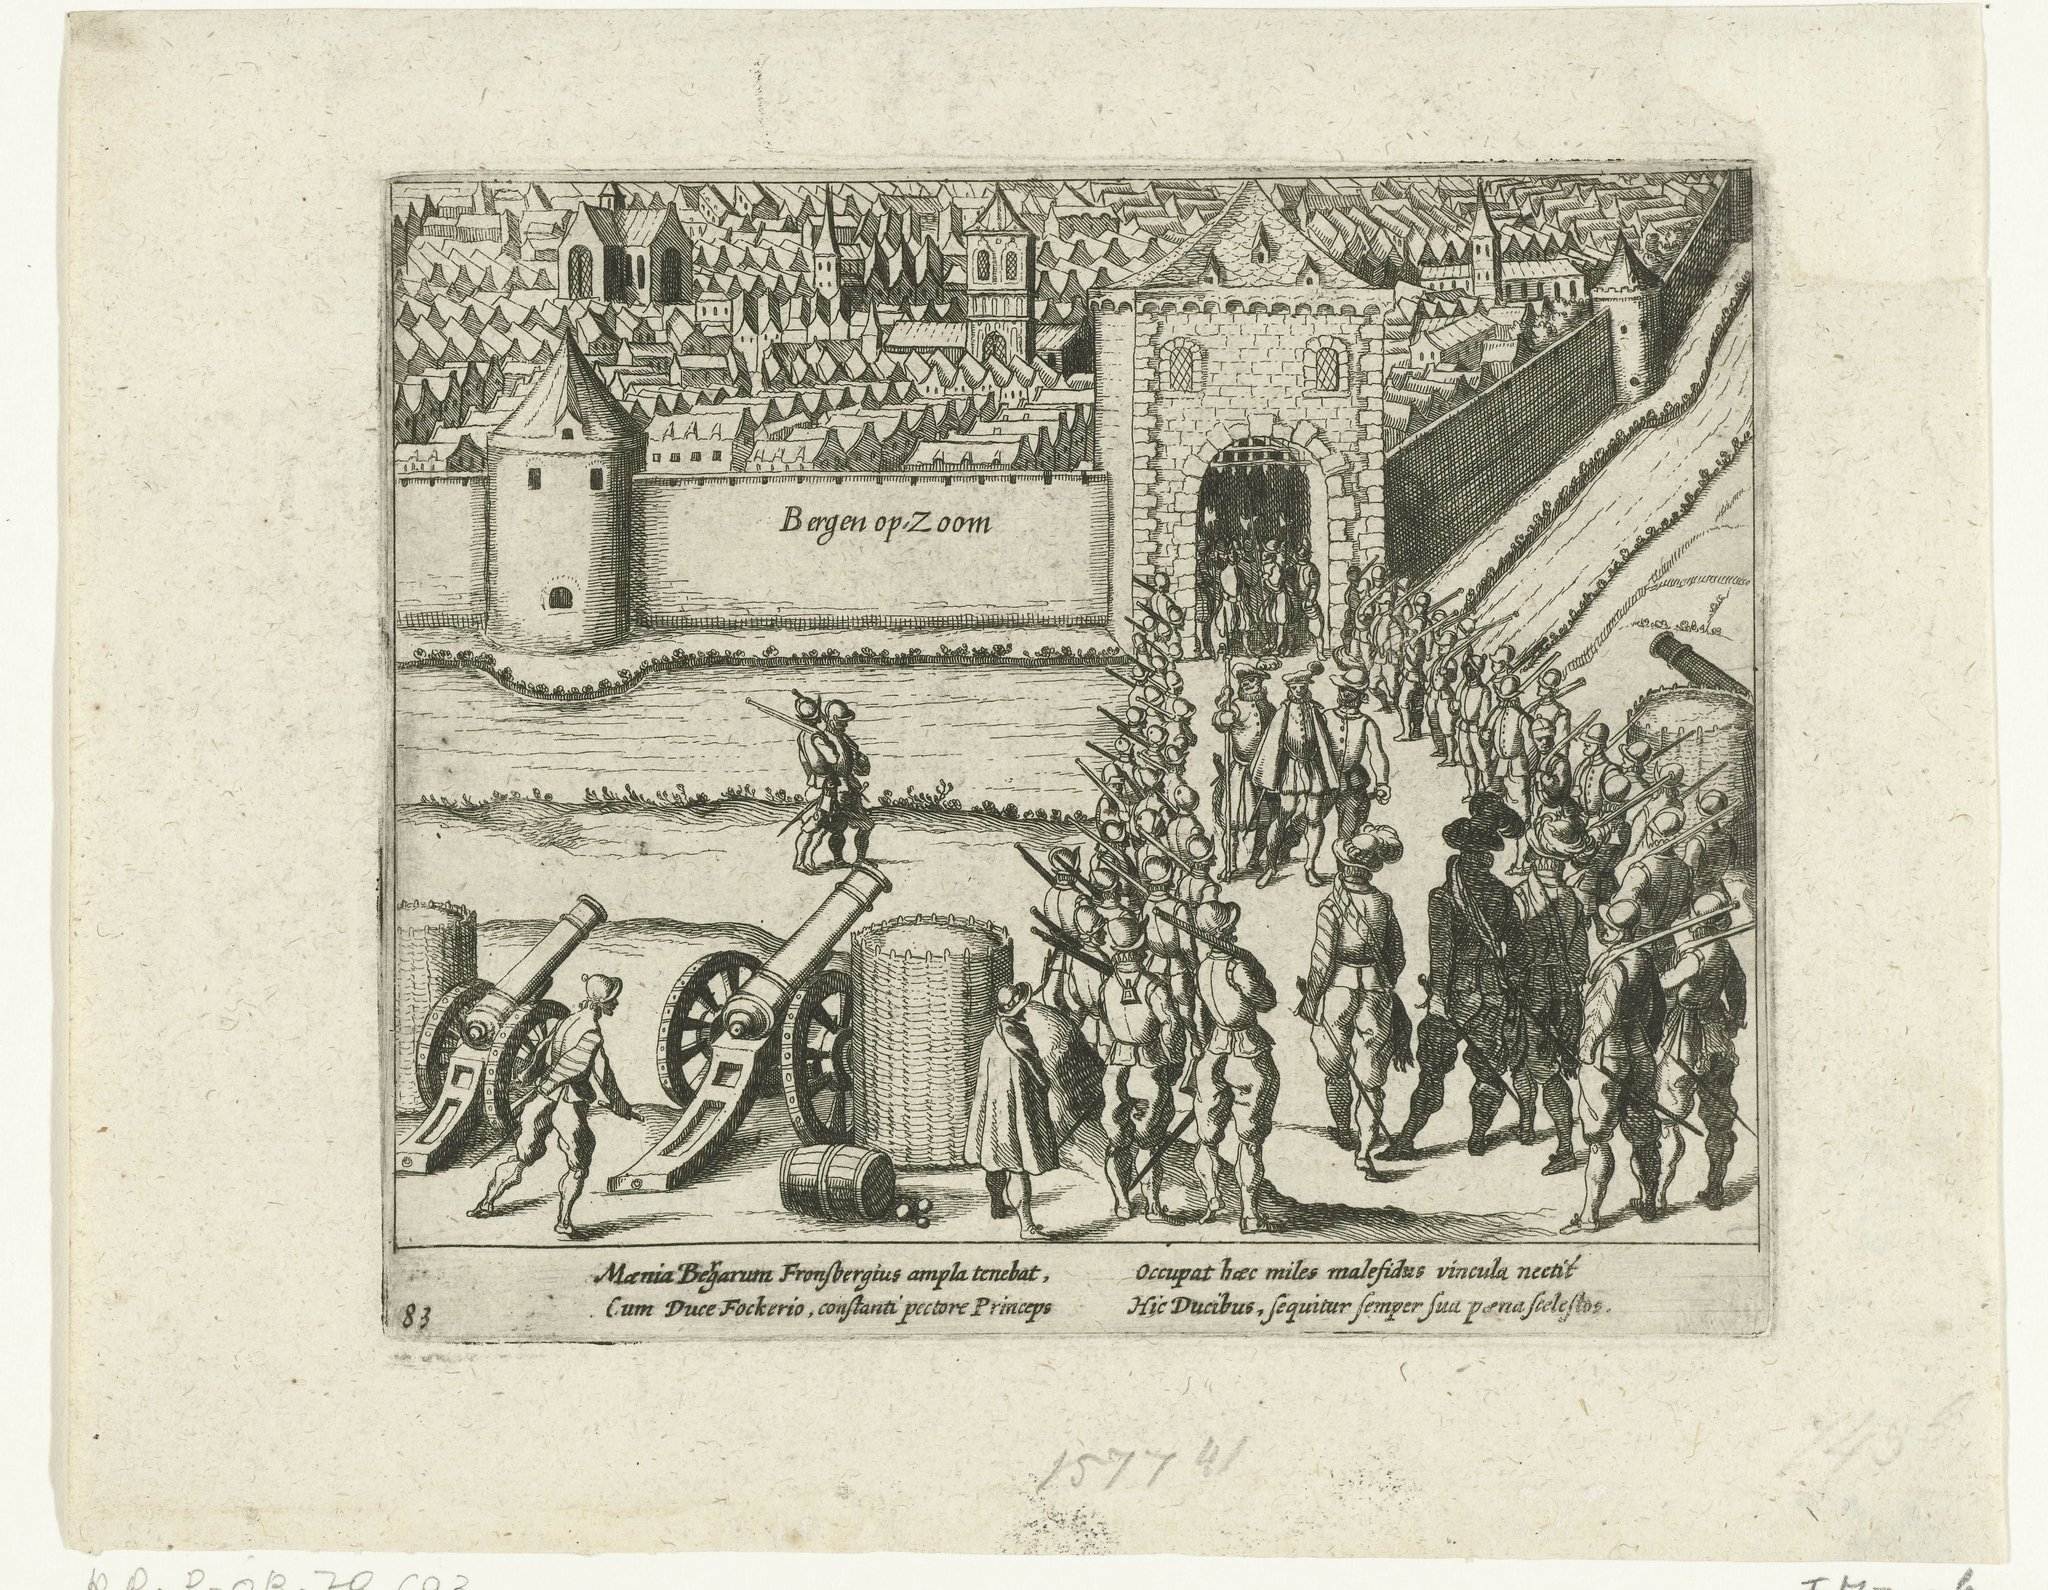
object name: print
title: Carl Fugger en Fronsberger gevangen genomen voor Bergen op Zoom, 1577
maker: simon frisius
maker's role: print maker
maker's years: 1570-1628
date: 1613-1615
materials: paper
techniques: etching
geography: northern netherlands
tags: augsburg, bergen op zoom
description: De Duitse legeraanvoerders Carl Fugger (Focker) en Fronsberger worden door de magistraat van Bergen op Zoom uitgeleverd aan het Staatse leger onder Champagney, 13 september 1577. Met onderschrift van 4 regels in het Latijn. Genummerd: 83. Onbedrukt op achterzijde.